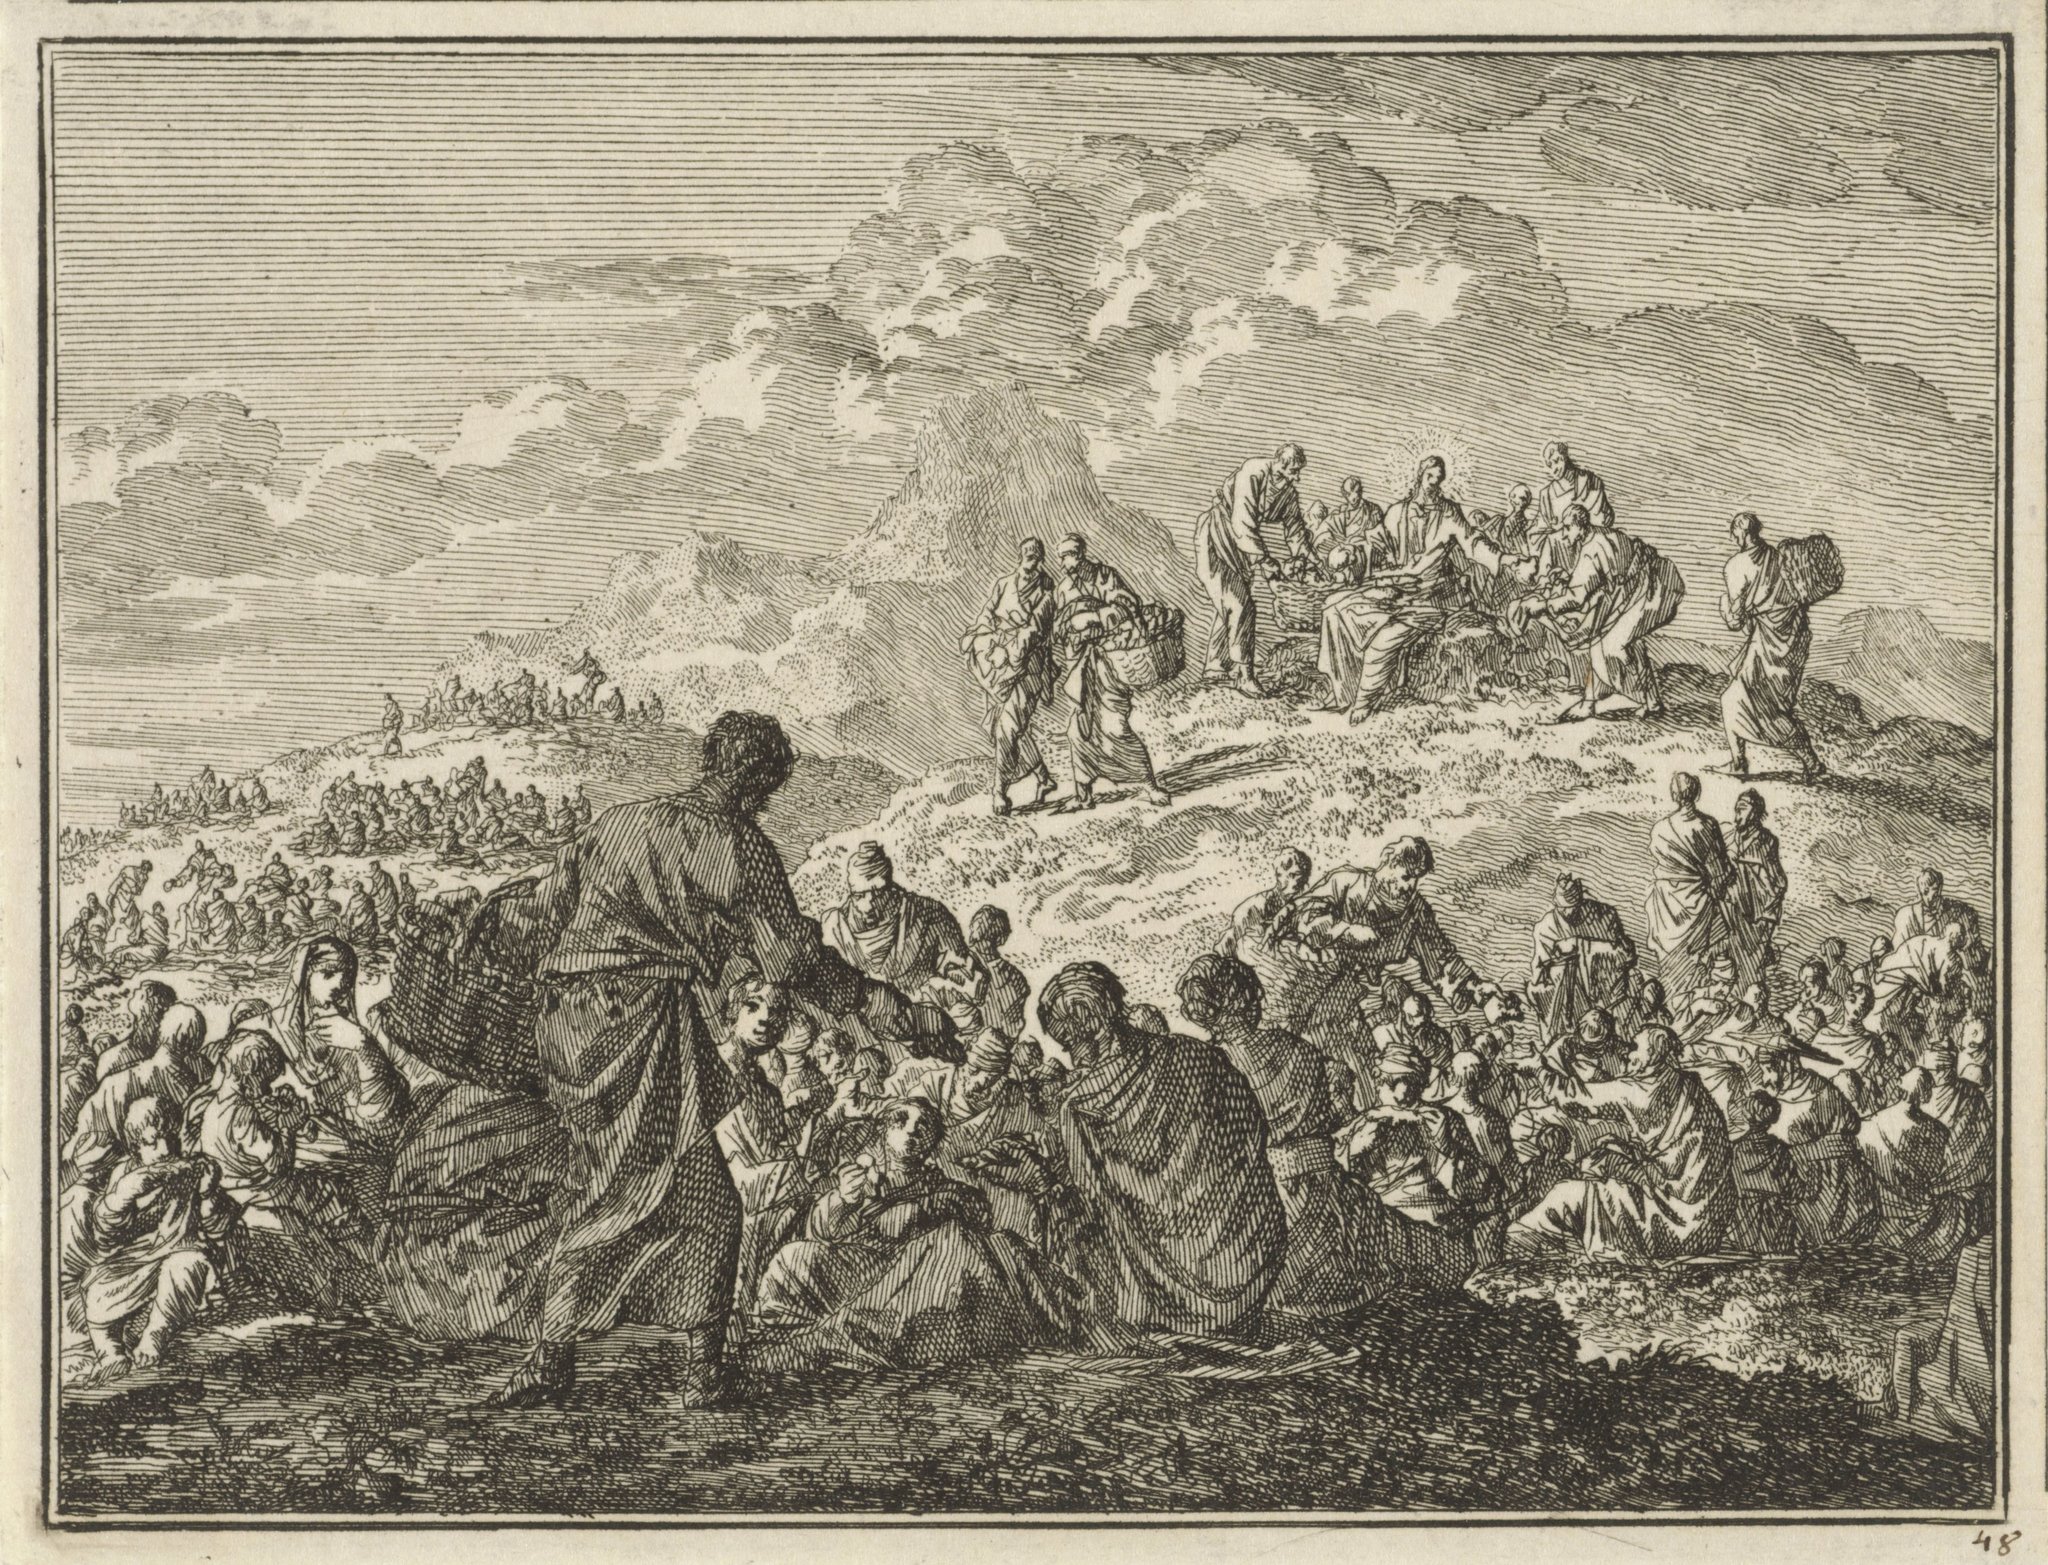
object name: print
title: Wonderbare spijziging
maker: jan luyken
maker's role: draughtsman, print maker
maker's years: 1649-1712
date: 1712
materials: paper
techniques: etching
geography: amsterdam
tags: multiplication of loaves and fishes for a multitude of four or five thousand people (matthew 14:13-21, 15:32-39; mark 6:32-44, 8:1-10; luke 9:10-17; john 6:1-14)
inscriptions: number: ‘48’, collector's mark: Lugt 2228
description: Proefdruk van illustratie uit: Luyken, Jan. De schriftuurlyke geschiedenissen en gelykenissen van het Oude en Nieuwe Verbond, 2 delen. Amsterdam: Wed. Pieter Arentsz II en Cornelis van der Sys, 1712, dl. II.